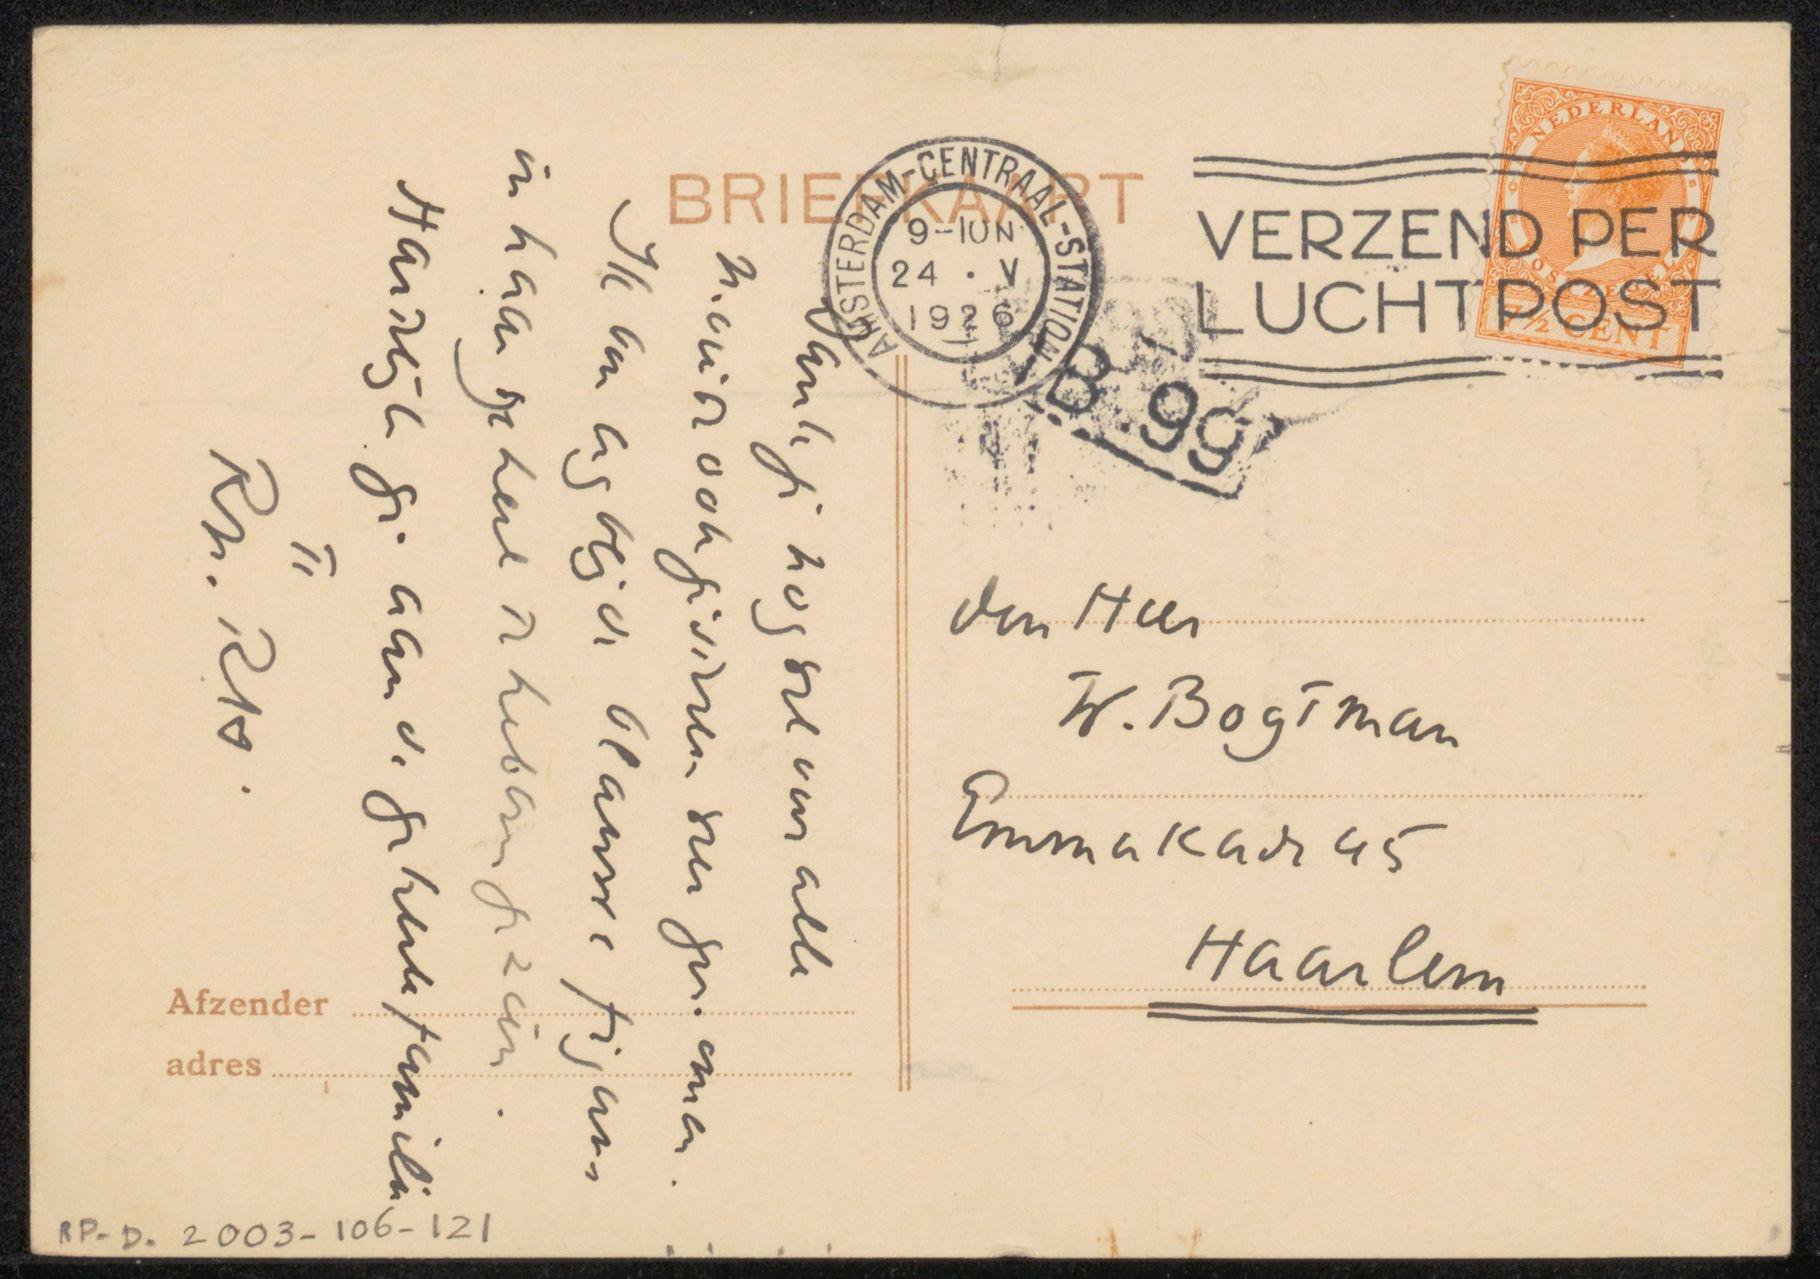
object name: postcard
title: Briefkaart aan Willem Bogtman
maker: richard nicolaüs roland holst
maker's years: 1868-1938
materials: cardboard, ink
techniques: pen, writing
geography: amsterdam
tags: indonesia, haarlem, willem bogtman, drawing, applied arts, arts and crafts; industrial design